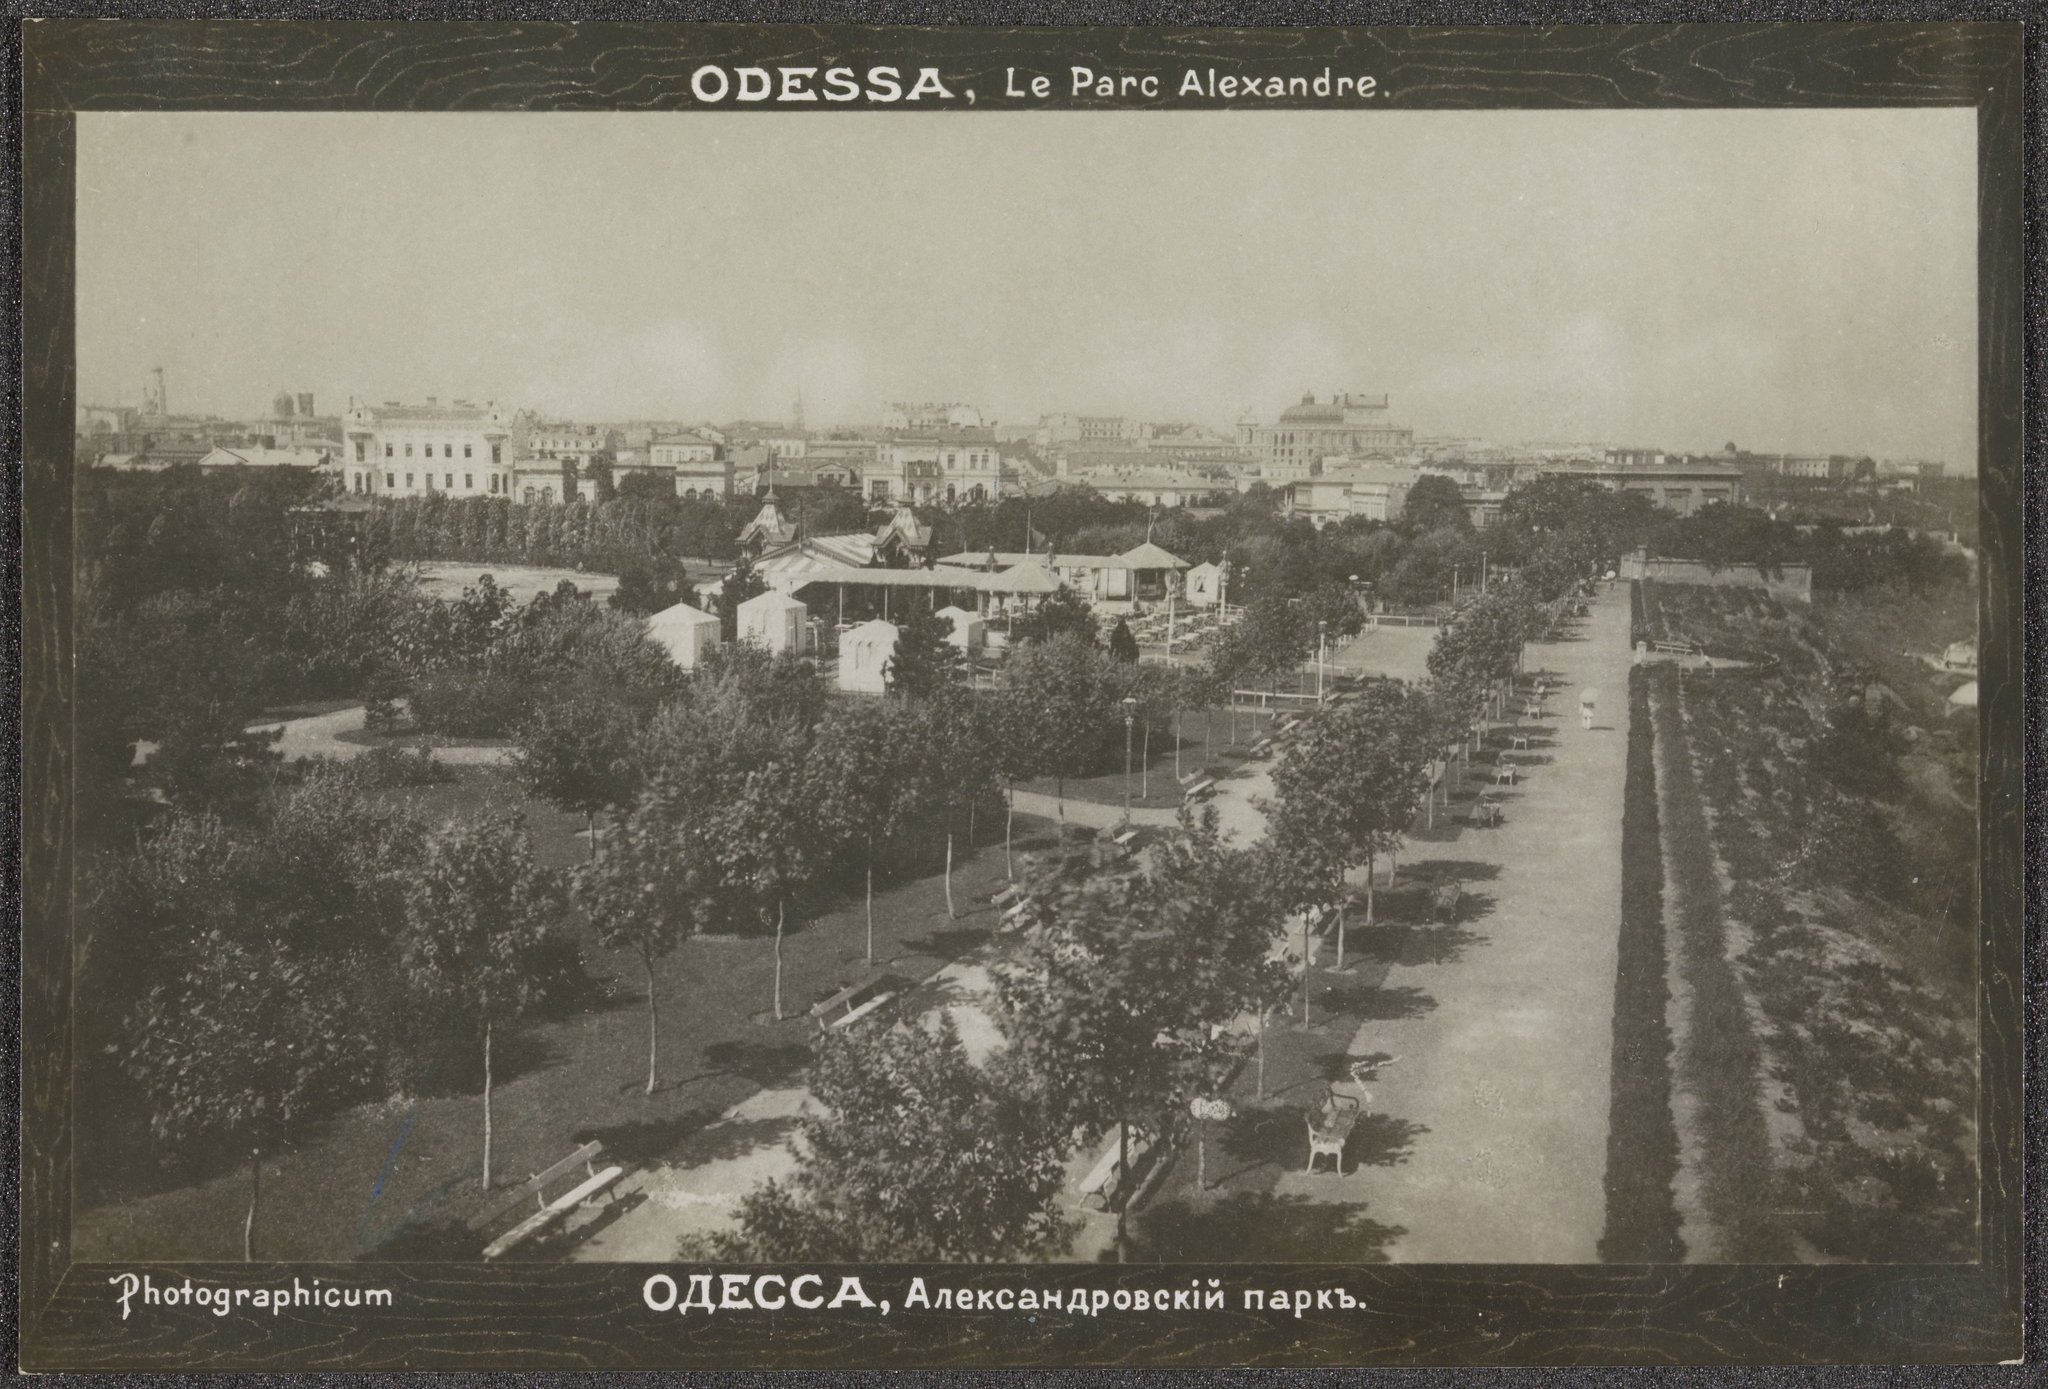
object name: photograph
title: Gezicht op het Alexanderpark in Odessa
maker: Anonymous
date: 1900-1930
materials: photographic support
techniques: gelatin silver print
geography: odessa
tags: public gardens, park (+ city(-scape) with figures, staffage)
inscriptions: inscription: ‘Photographicum’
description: Onderdeel van Fotoalbum met opnames van bezienswaardigheden in Odessa.